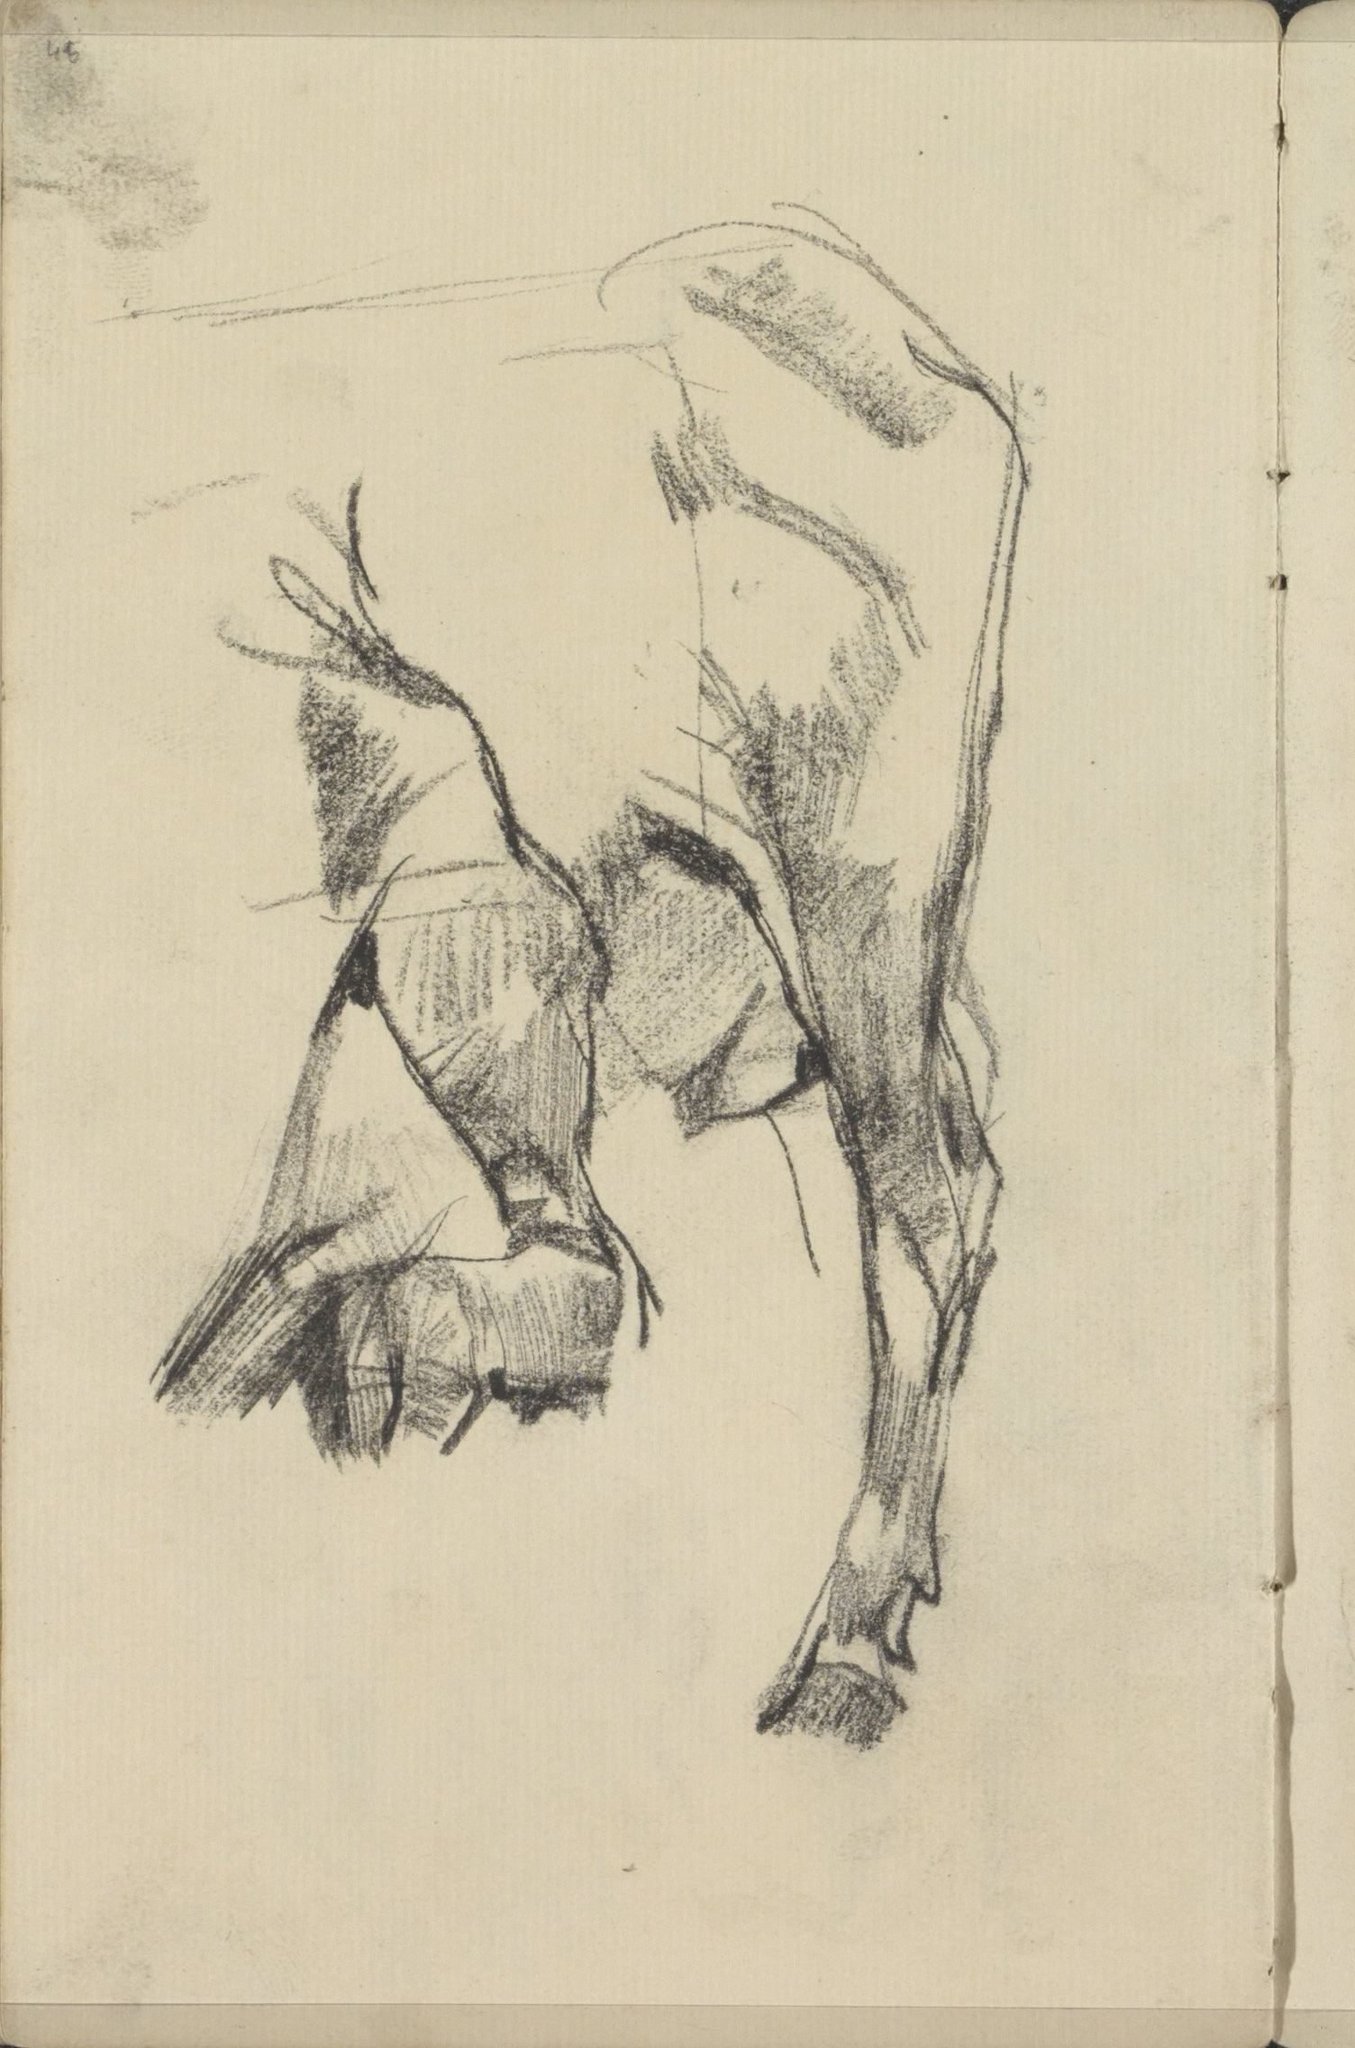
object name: sketchbook leaf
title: Koe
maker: george hendrik breitner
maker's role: draughtsman, painter, print maker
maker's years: 1857-1923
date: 1883-1884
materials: chalk, paper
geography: the hague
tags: cow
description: Pagina 45 uit een schetsboek met 23 bladen.